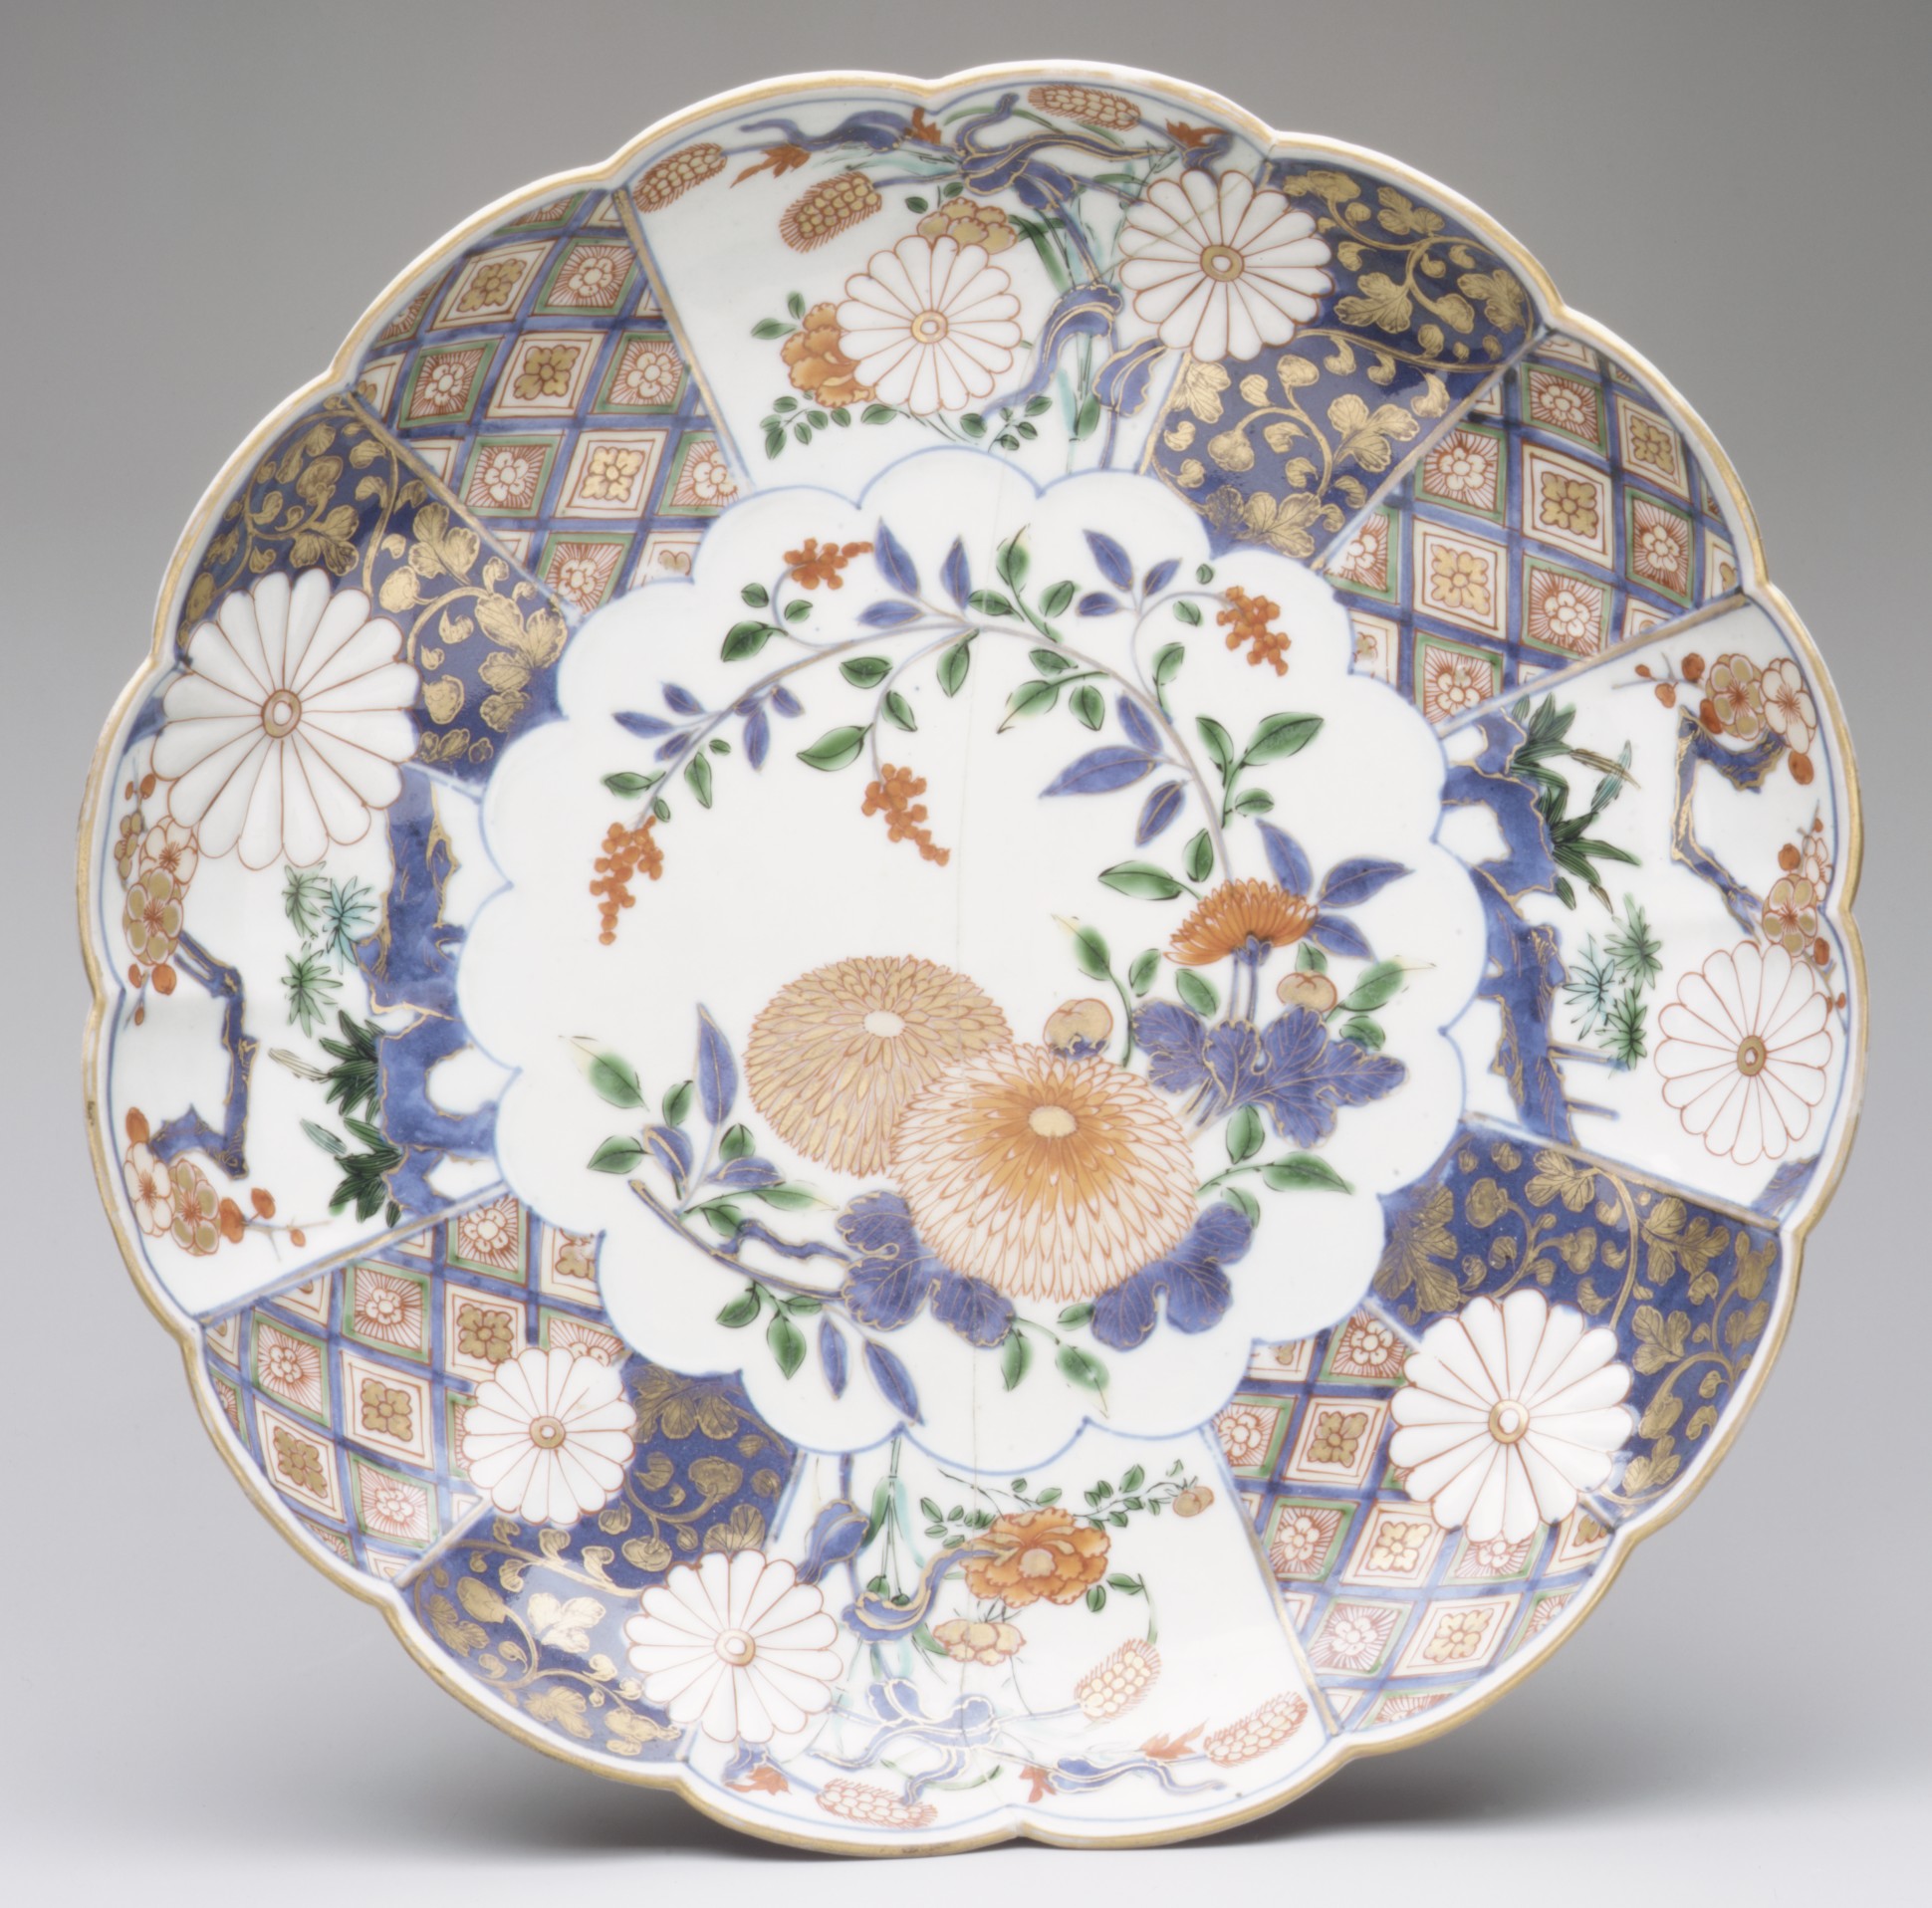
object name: dish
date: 1710-1730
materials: hard paste porcelain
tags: flowers